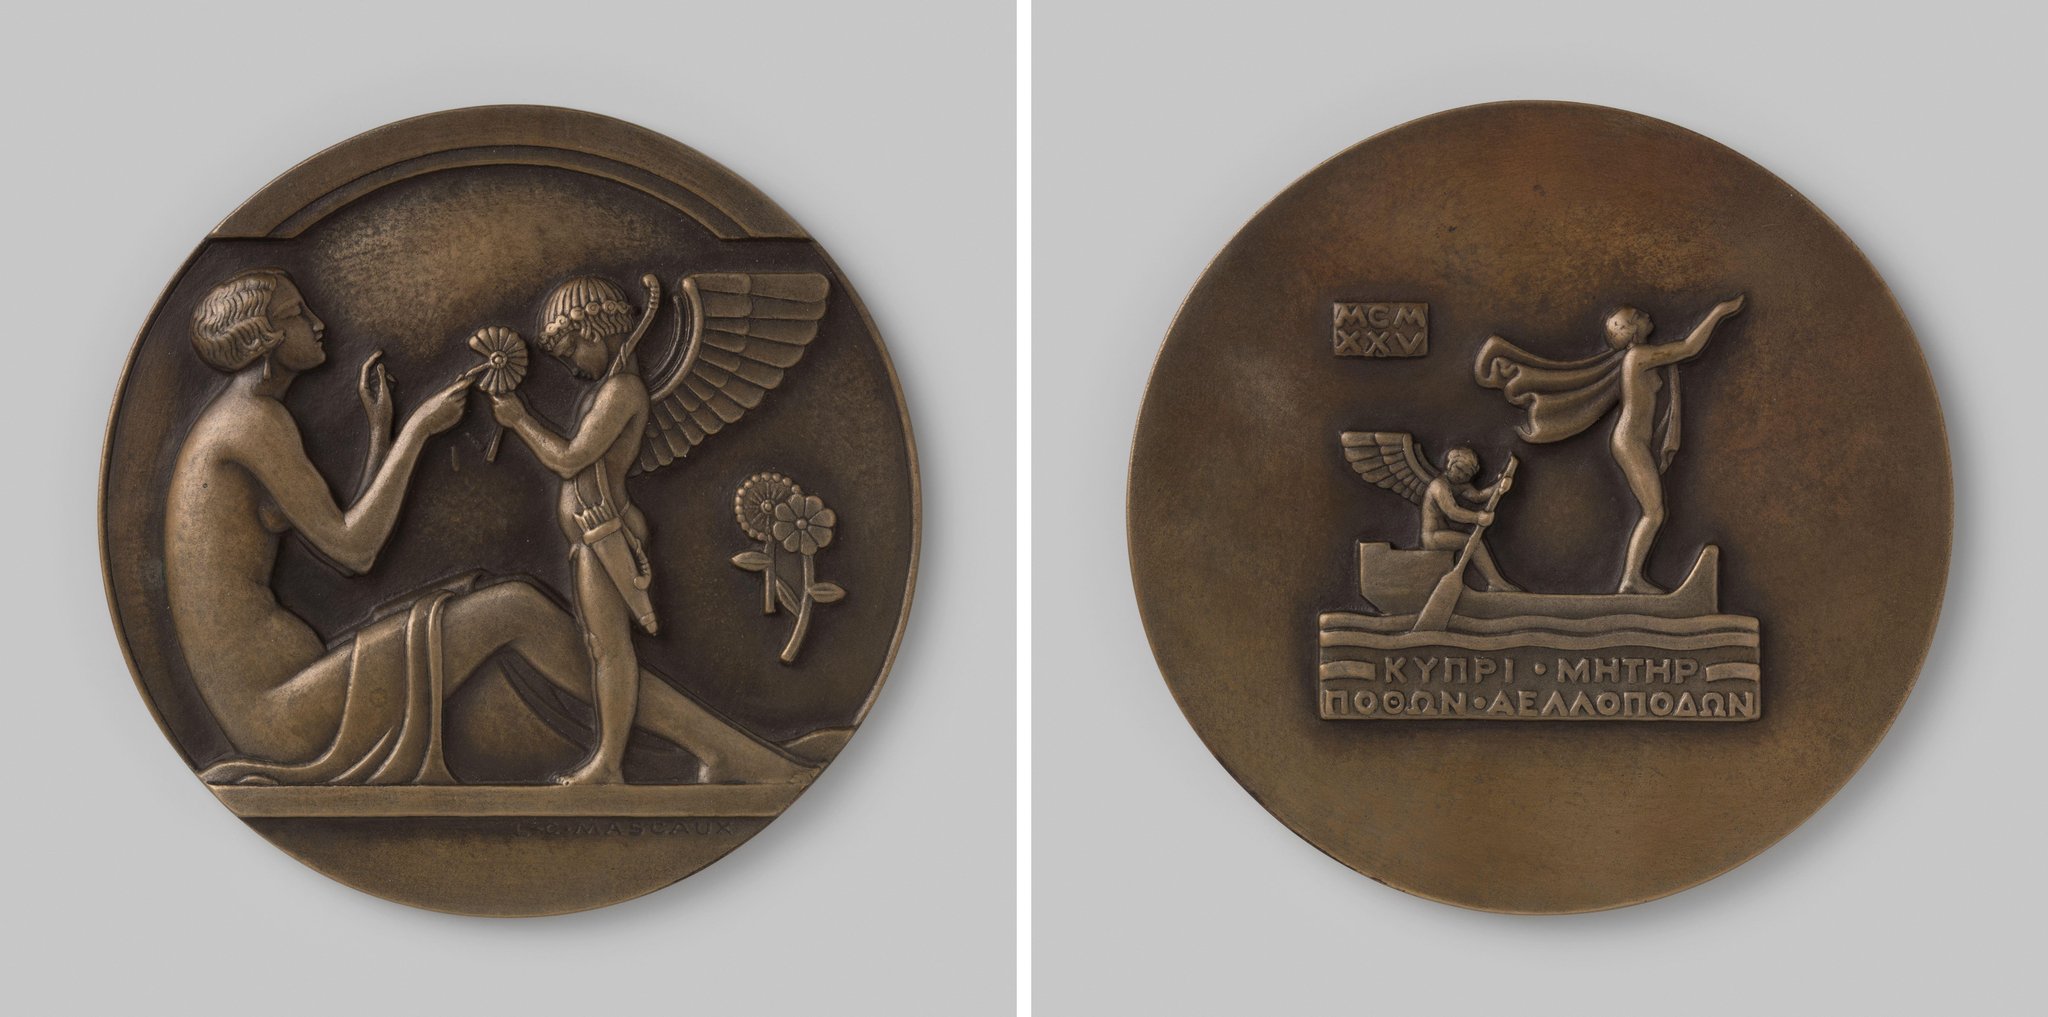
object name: history medal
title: Aphrodite en Eros (1925)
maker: l.-c. mascaux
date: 1925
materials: bronze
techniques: casting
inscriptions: number: ‘132’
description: Grote bronzen penning, op de voorzijde Aphrodite zittend, blaadjes plukkend van een bloem voorgehouden door de gevleugelde Eros, met rechts twee bloemen, op de keerzijde Aprodite staand op een boot gestuurd door Eros.